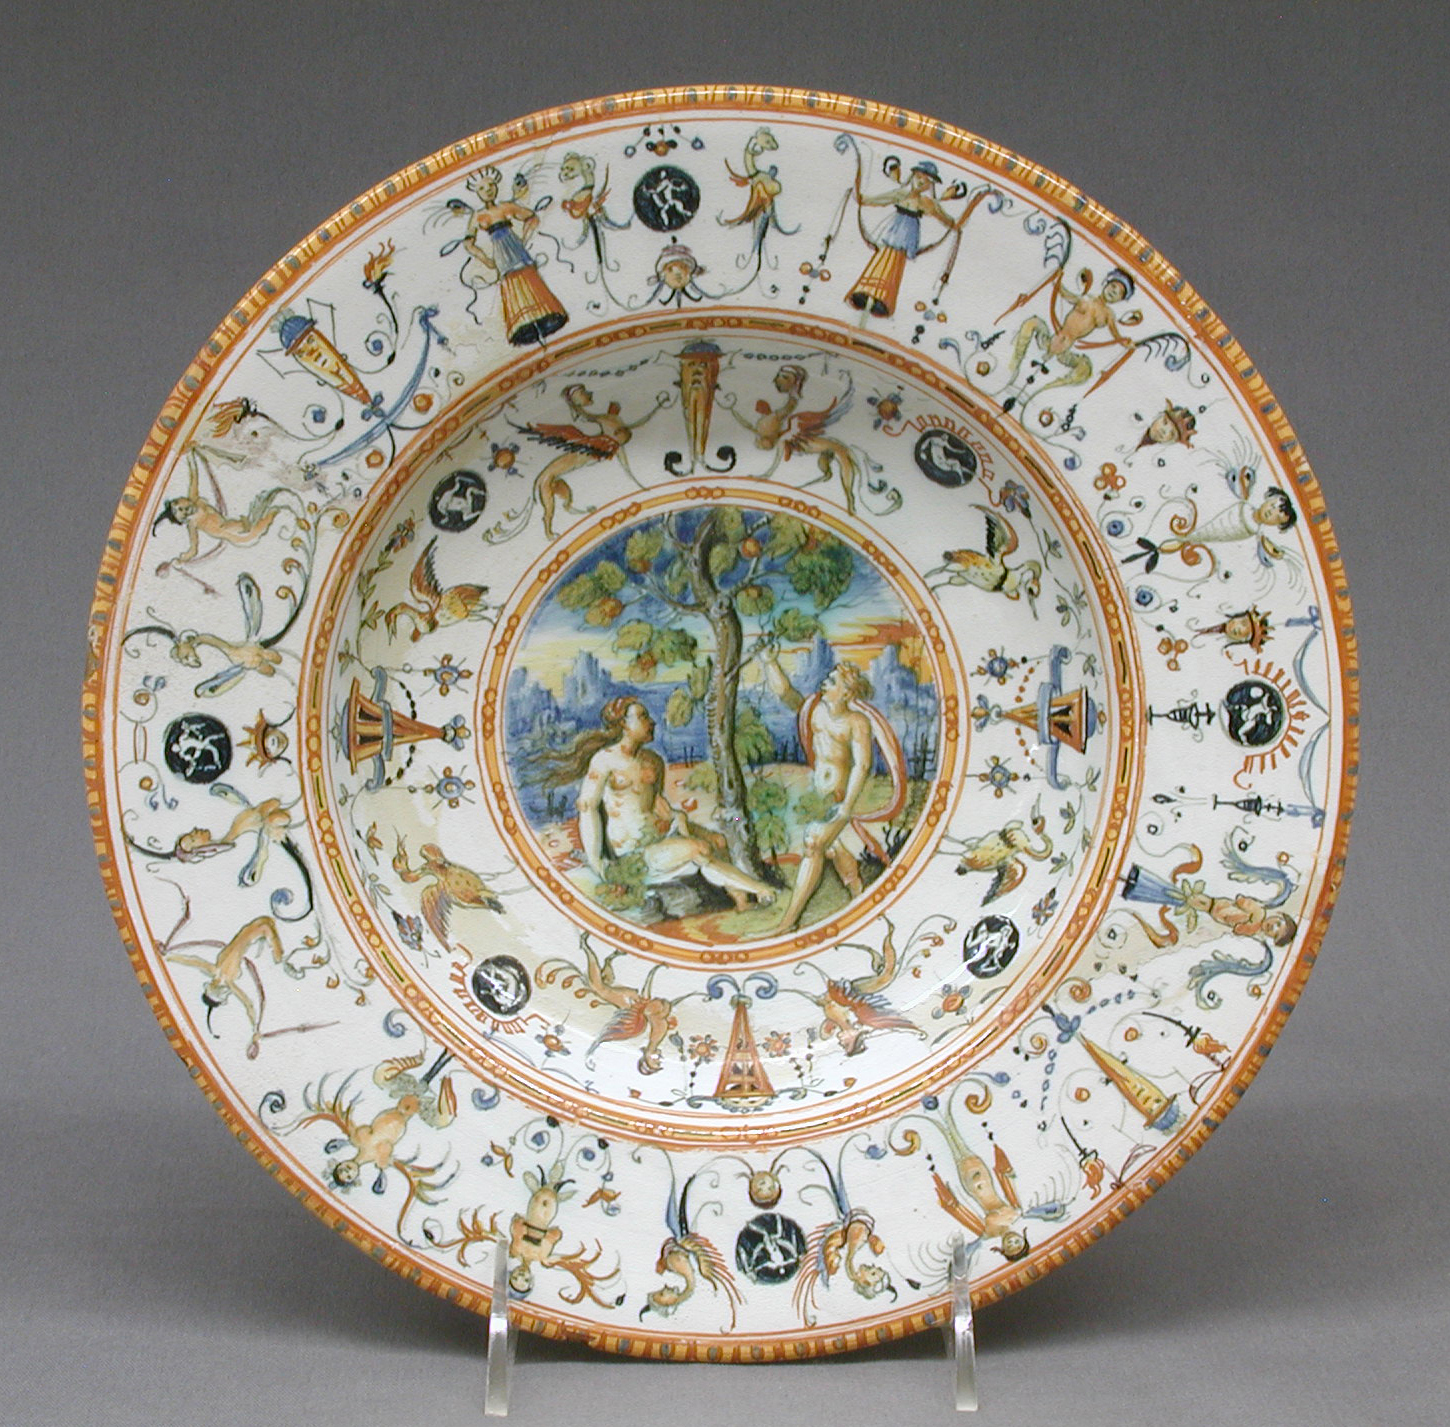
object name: dish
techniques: maiolica, glazing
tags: birds,male nudes,female nudes,trees